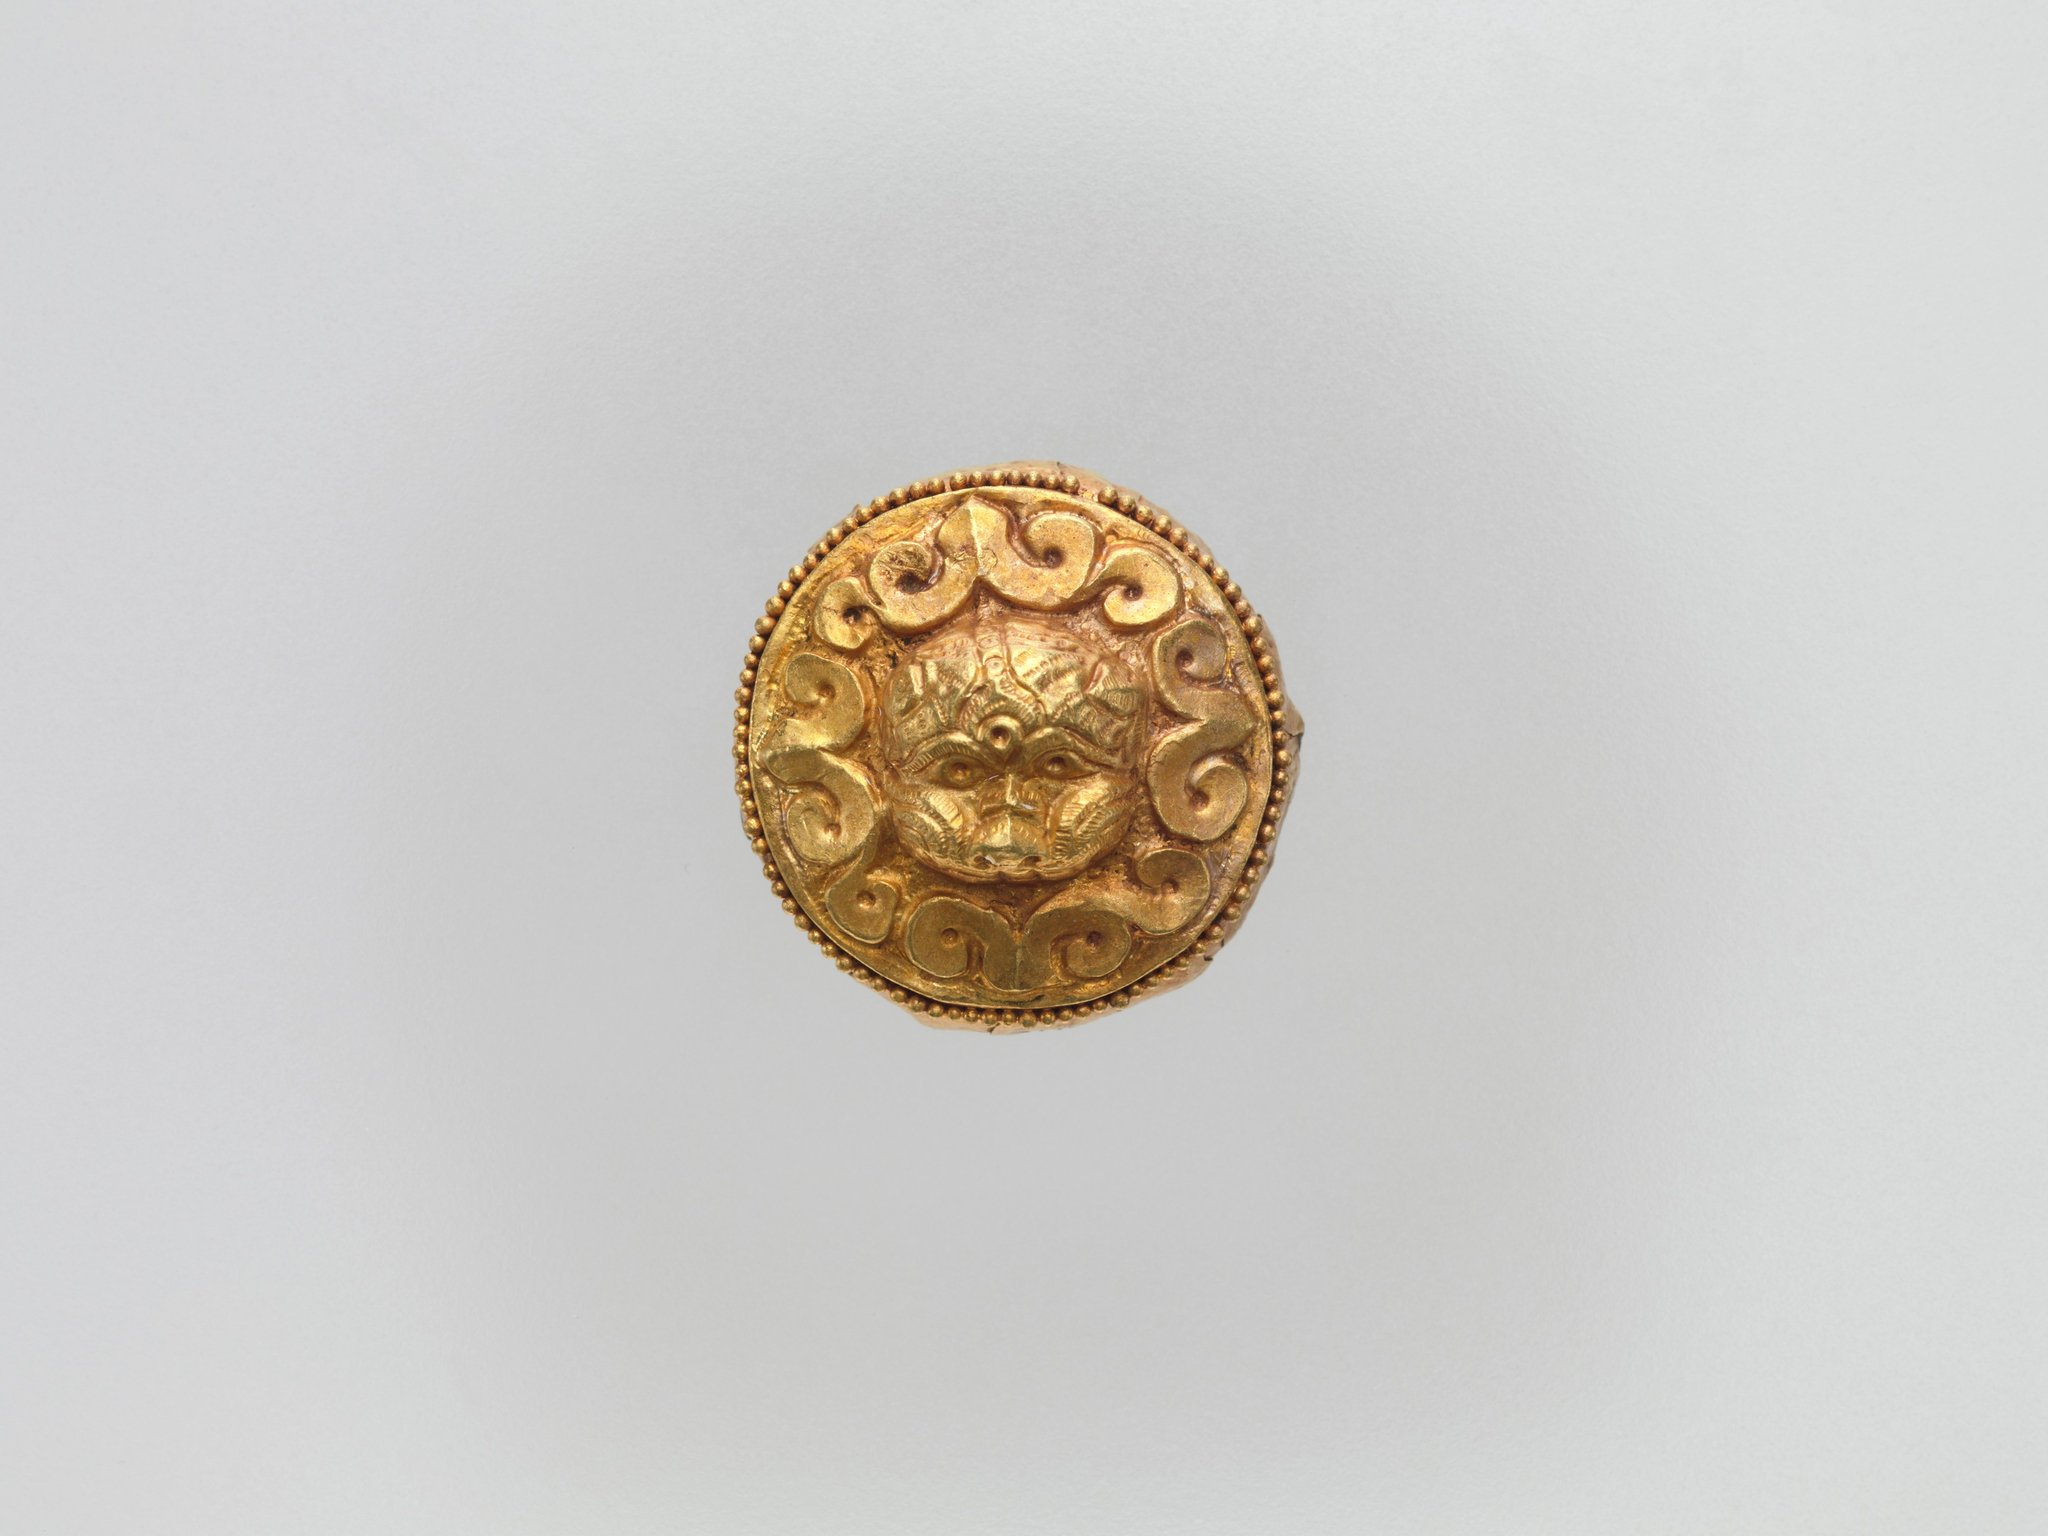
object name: plaque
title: Cap-Shaped Plaque with Lion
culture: chinese or central asian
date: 601-900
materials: gold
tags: lions